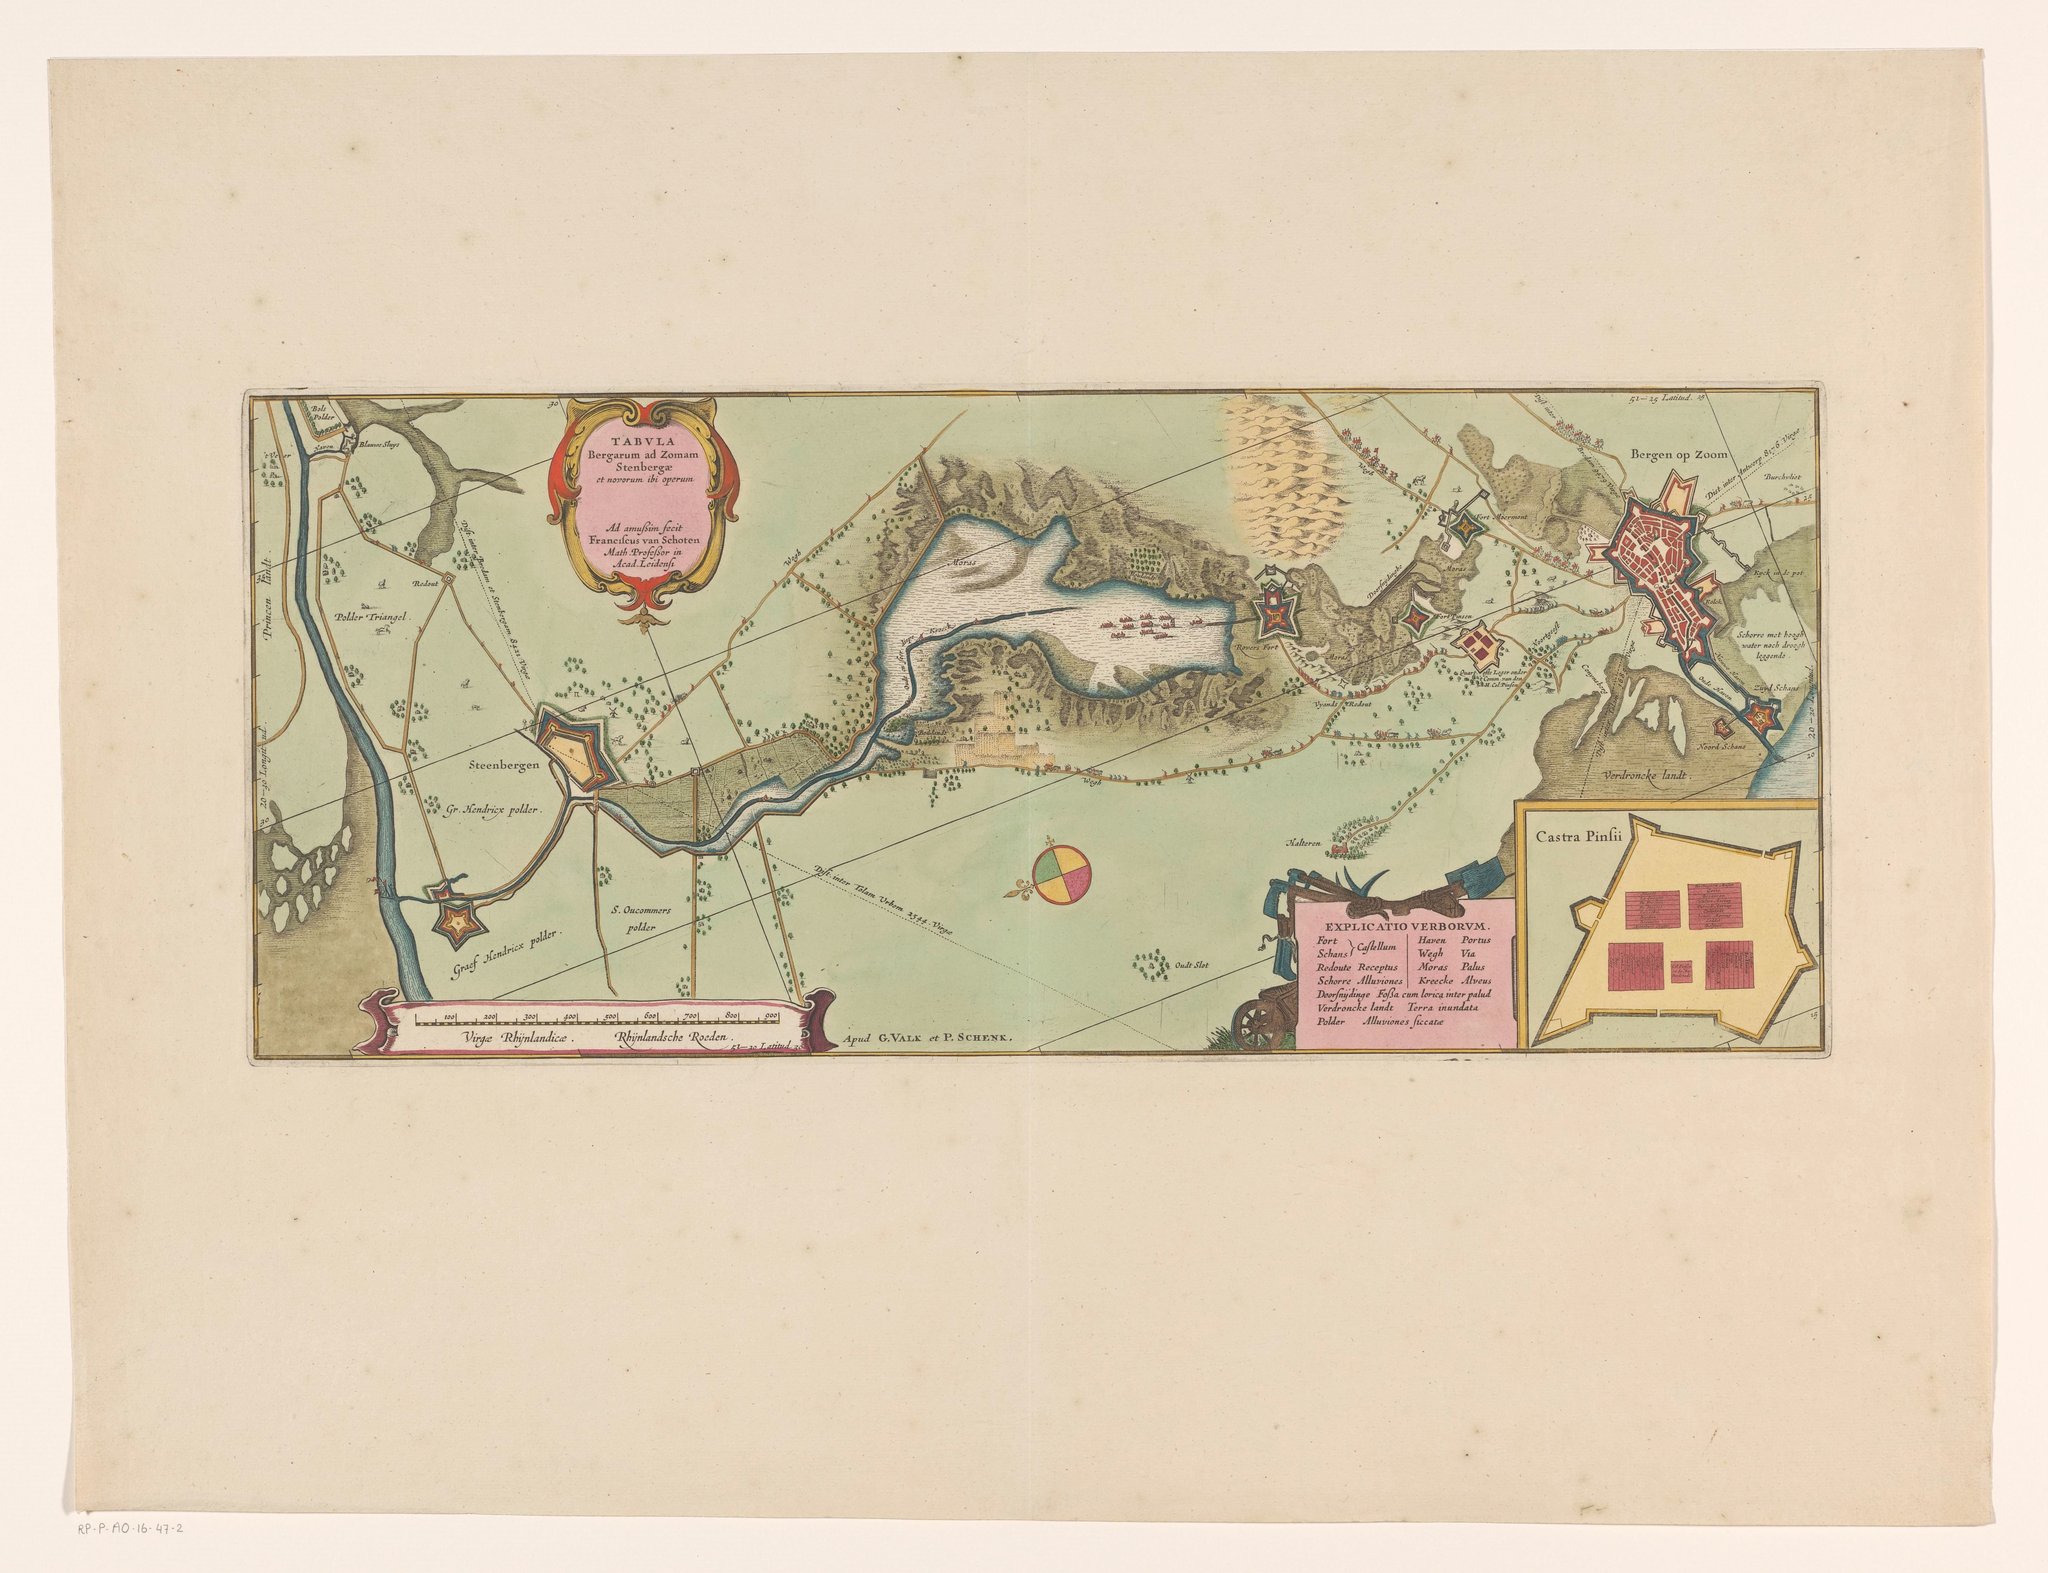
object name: print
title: Kaart van het Beleg van Bergen op Zoom, 1622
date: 1636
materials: paper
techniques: engraving, etching, hand coloring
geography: amsterdam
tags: maps of separate countries or regions, bergen op zoom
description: Kaart van het mislukte Beleg van Bergen op Zoom door het Spaanse leger onder Spinola en Velasco, 18 juli - 3 oktober 1622. Kaart van Bergen op Zoom met het gebied tot Steenbergen. Linksboven een cartouche met Latijnse titel. Rechtsonder een inzet met de plattegrond van het Fort Pinsen (Castra Pinsii). Links van de inzet een woordenverklaring Nederlands-Latijn. Linksonder een schaalstok: 900 Virgae Rhijnlandicae / 900 Rhijnlandsche Roeden. De kaart is voorzien van een coördinaten-net en gradenverdeling.